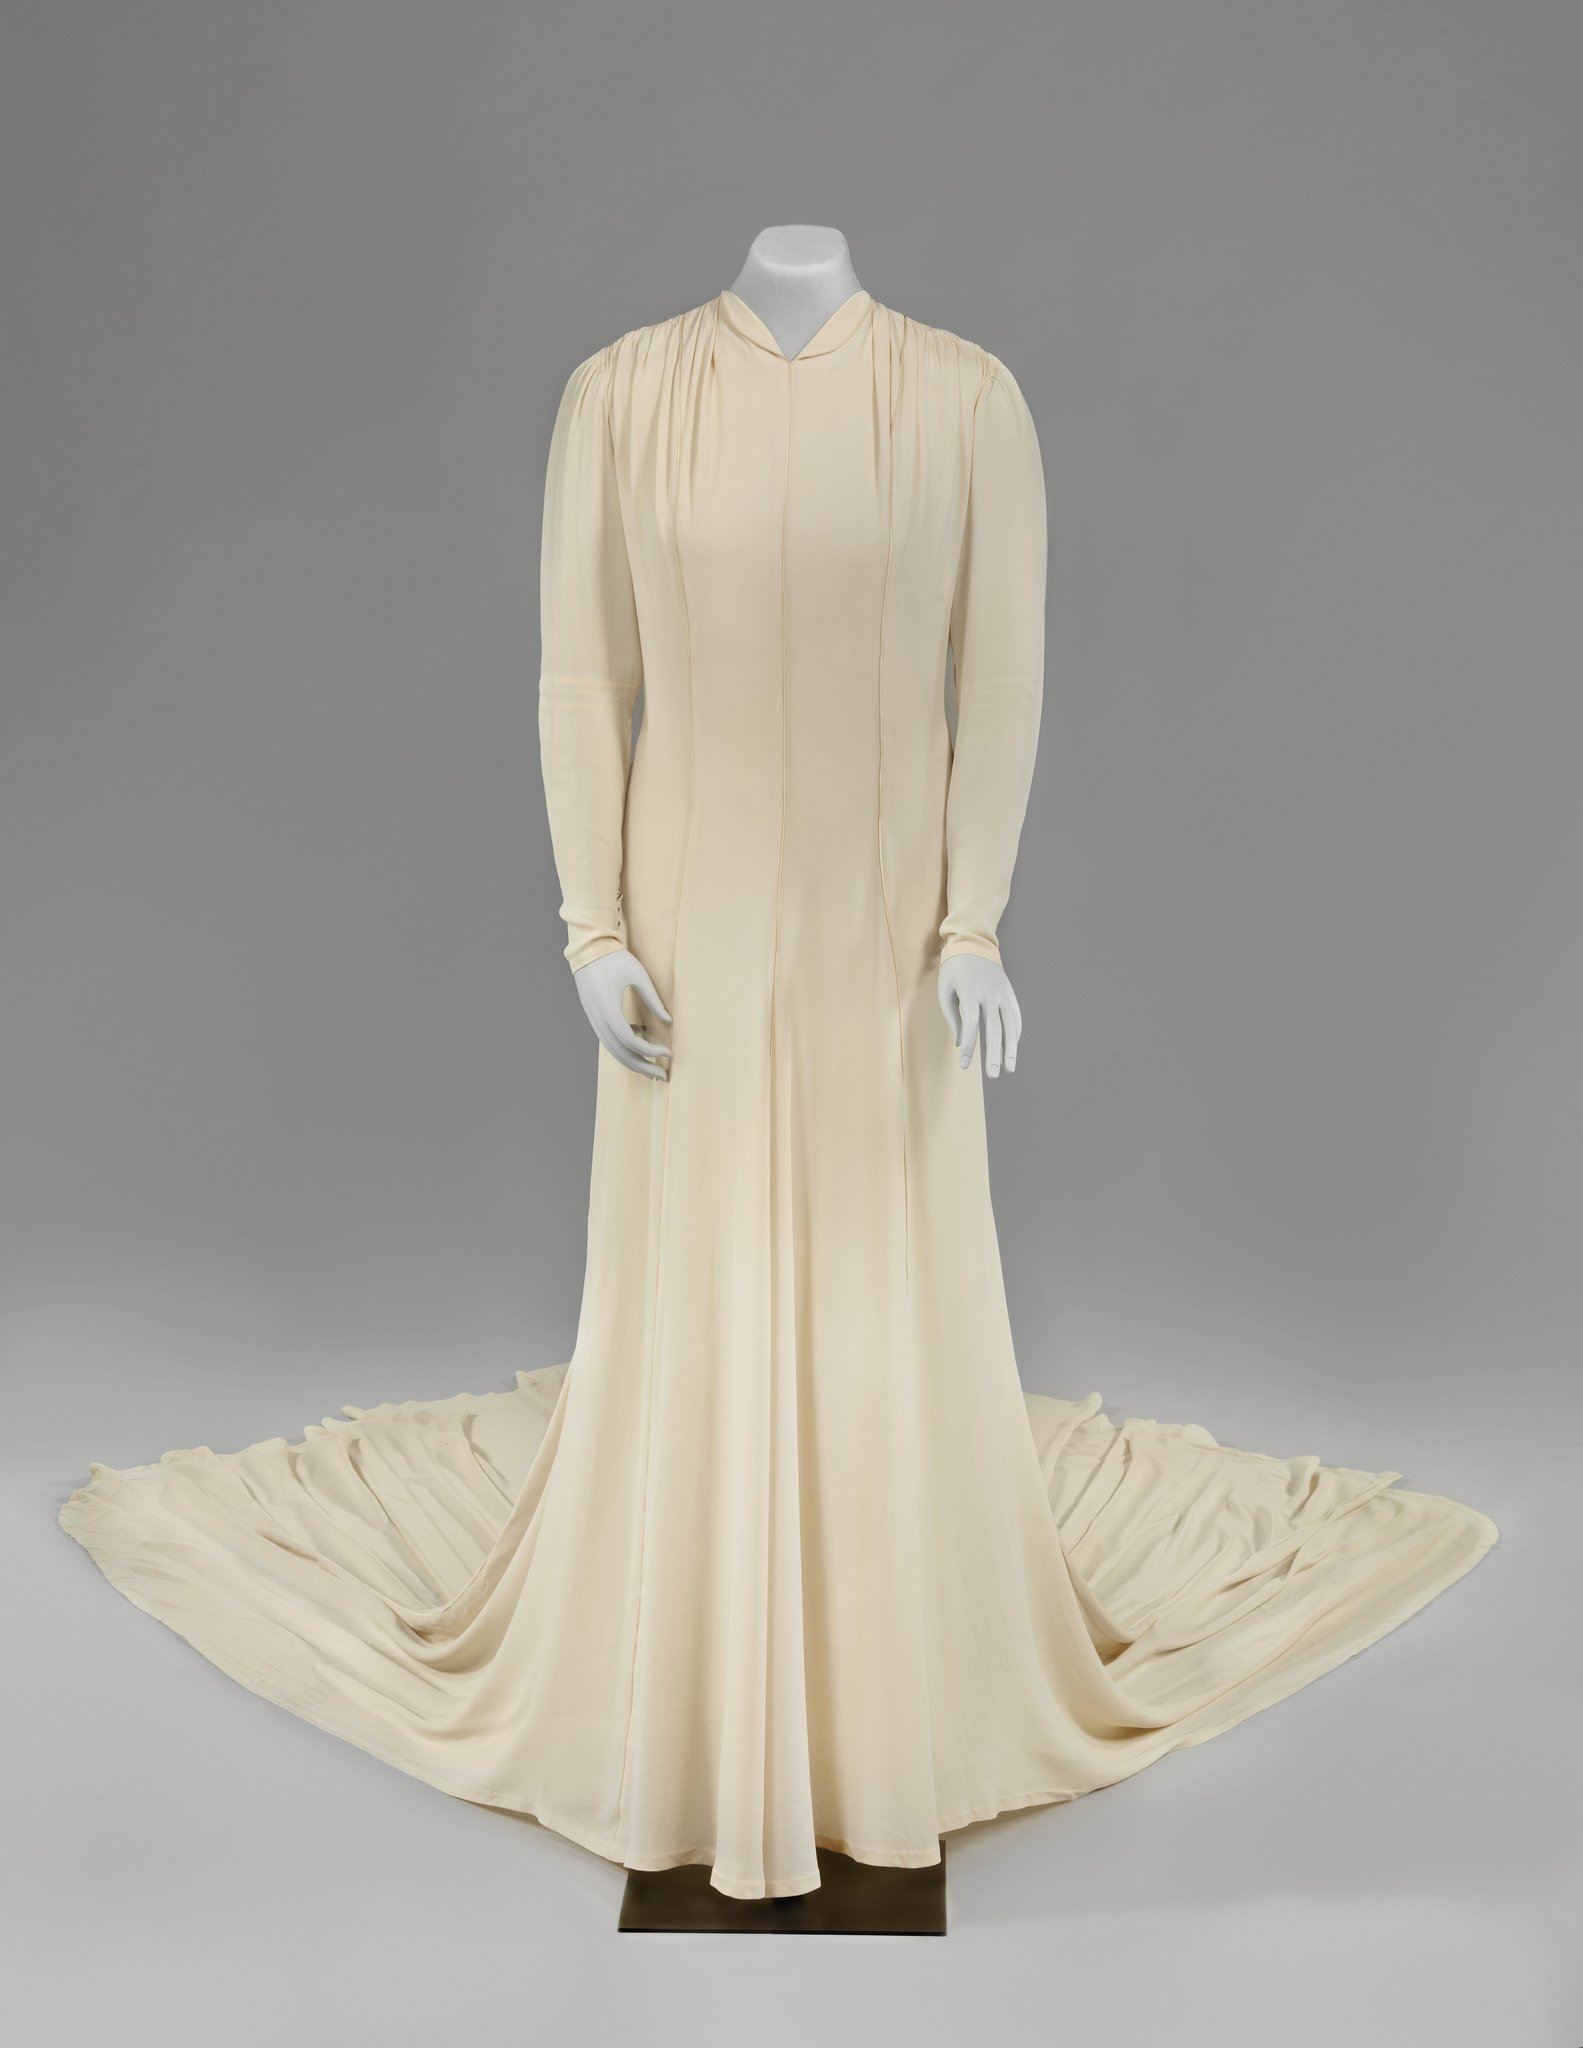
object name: wedding dress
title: Bruidsjapon van crème charmeuse zijde met lange sleep, sluik model met kleine v-hals en achtersluiting met lange rij stofknoopjes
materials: silk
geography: amsterdam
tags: the hague, amsterdam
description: Oorspronkelijk zouden de rug en de sleep van de jurk versierd worden met een strook kant van een albe, een erfstuk uit de familie in bezit van mw. Six-Bosch Reitz. Brief C.I. Six, d.d. 26-05-1939:' De bruid had een bouwsel van echte oranje bloesem op het hoofd, hetgeen helaas wat te hoog en te zwaar uitgevallen was. De mooie oude Vlaamsche kant (BK-1991-13?), die Mama haar gaf had de naaister per see op de sluier willen gebruiken, dit was jammer want het maakte weinig effect en sneed ons door de ziel toen wij die arme kostbare oude kant telkens met de sluier over de grond zagen slepen. De jurk zelf voldeed wel veel beter met de waas van de sluier er over heen, dan op de receptie.' (Archief Six)